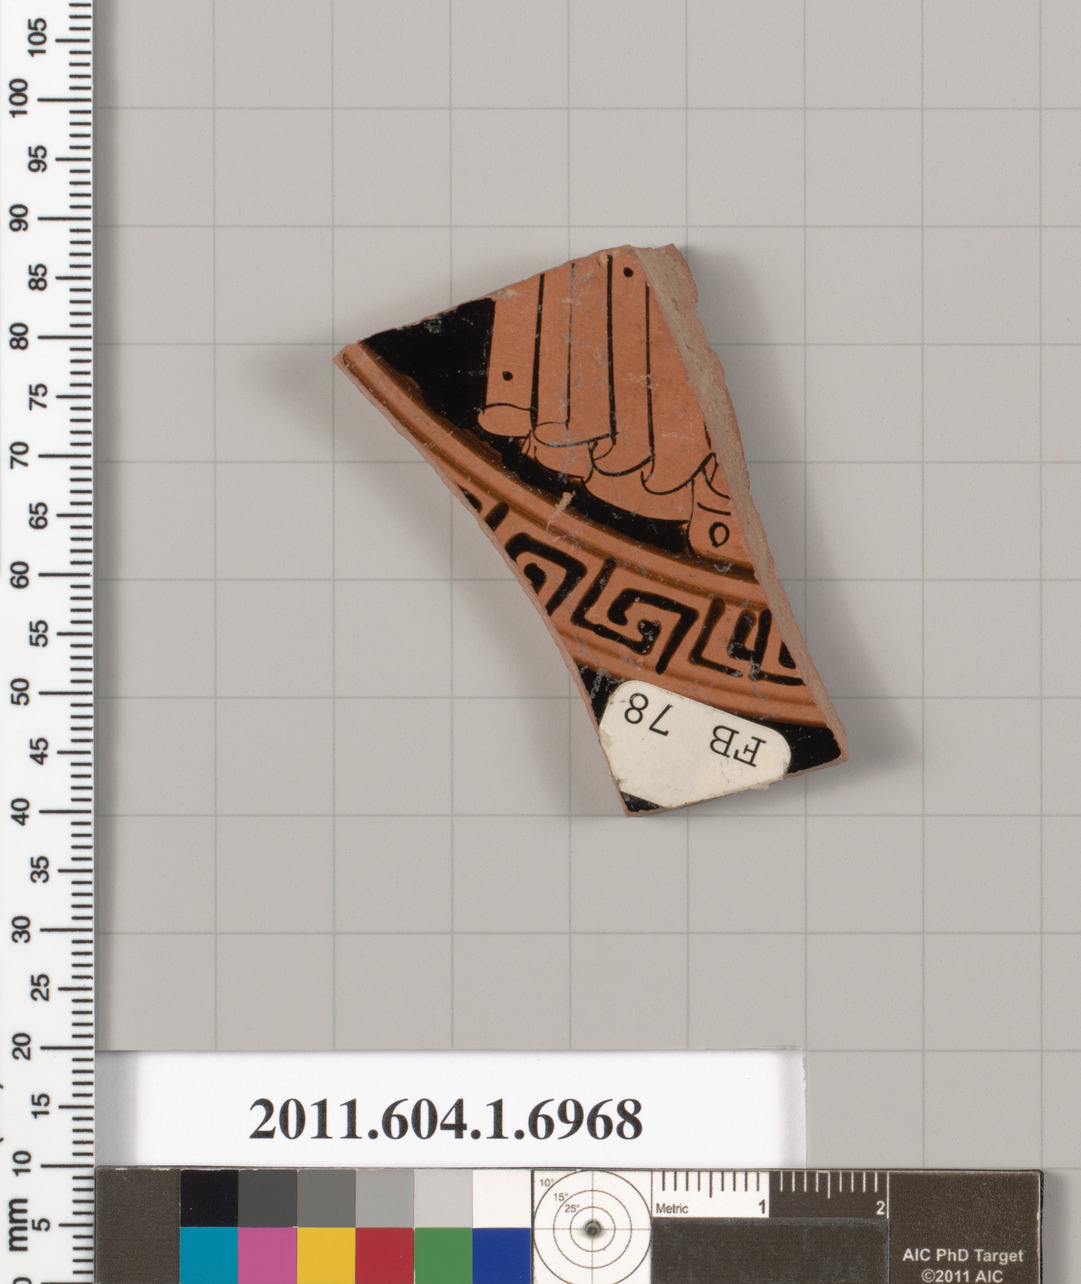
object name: kylix fragment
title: Terracotta fragment of a kylix (drinking cup)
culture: greek, attic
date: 490-470 BCE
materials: terracotta